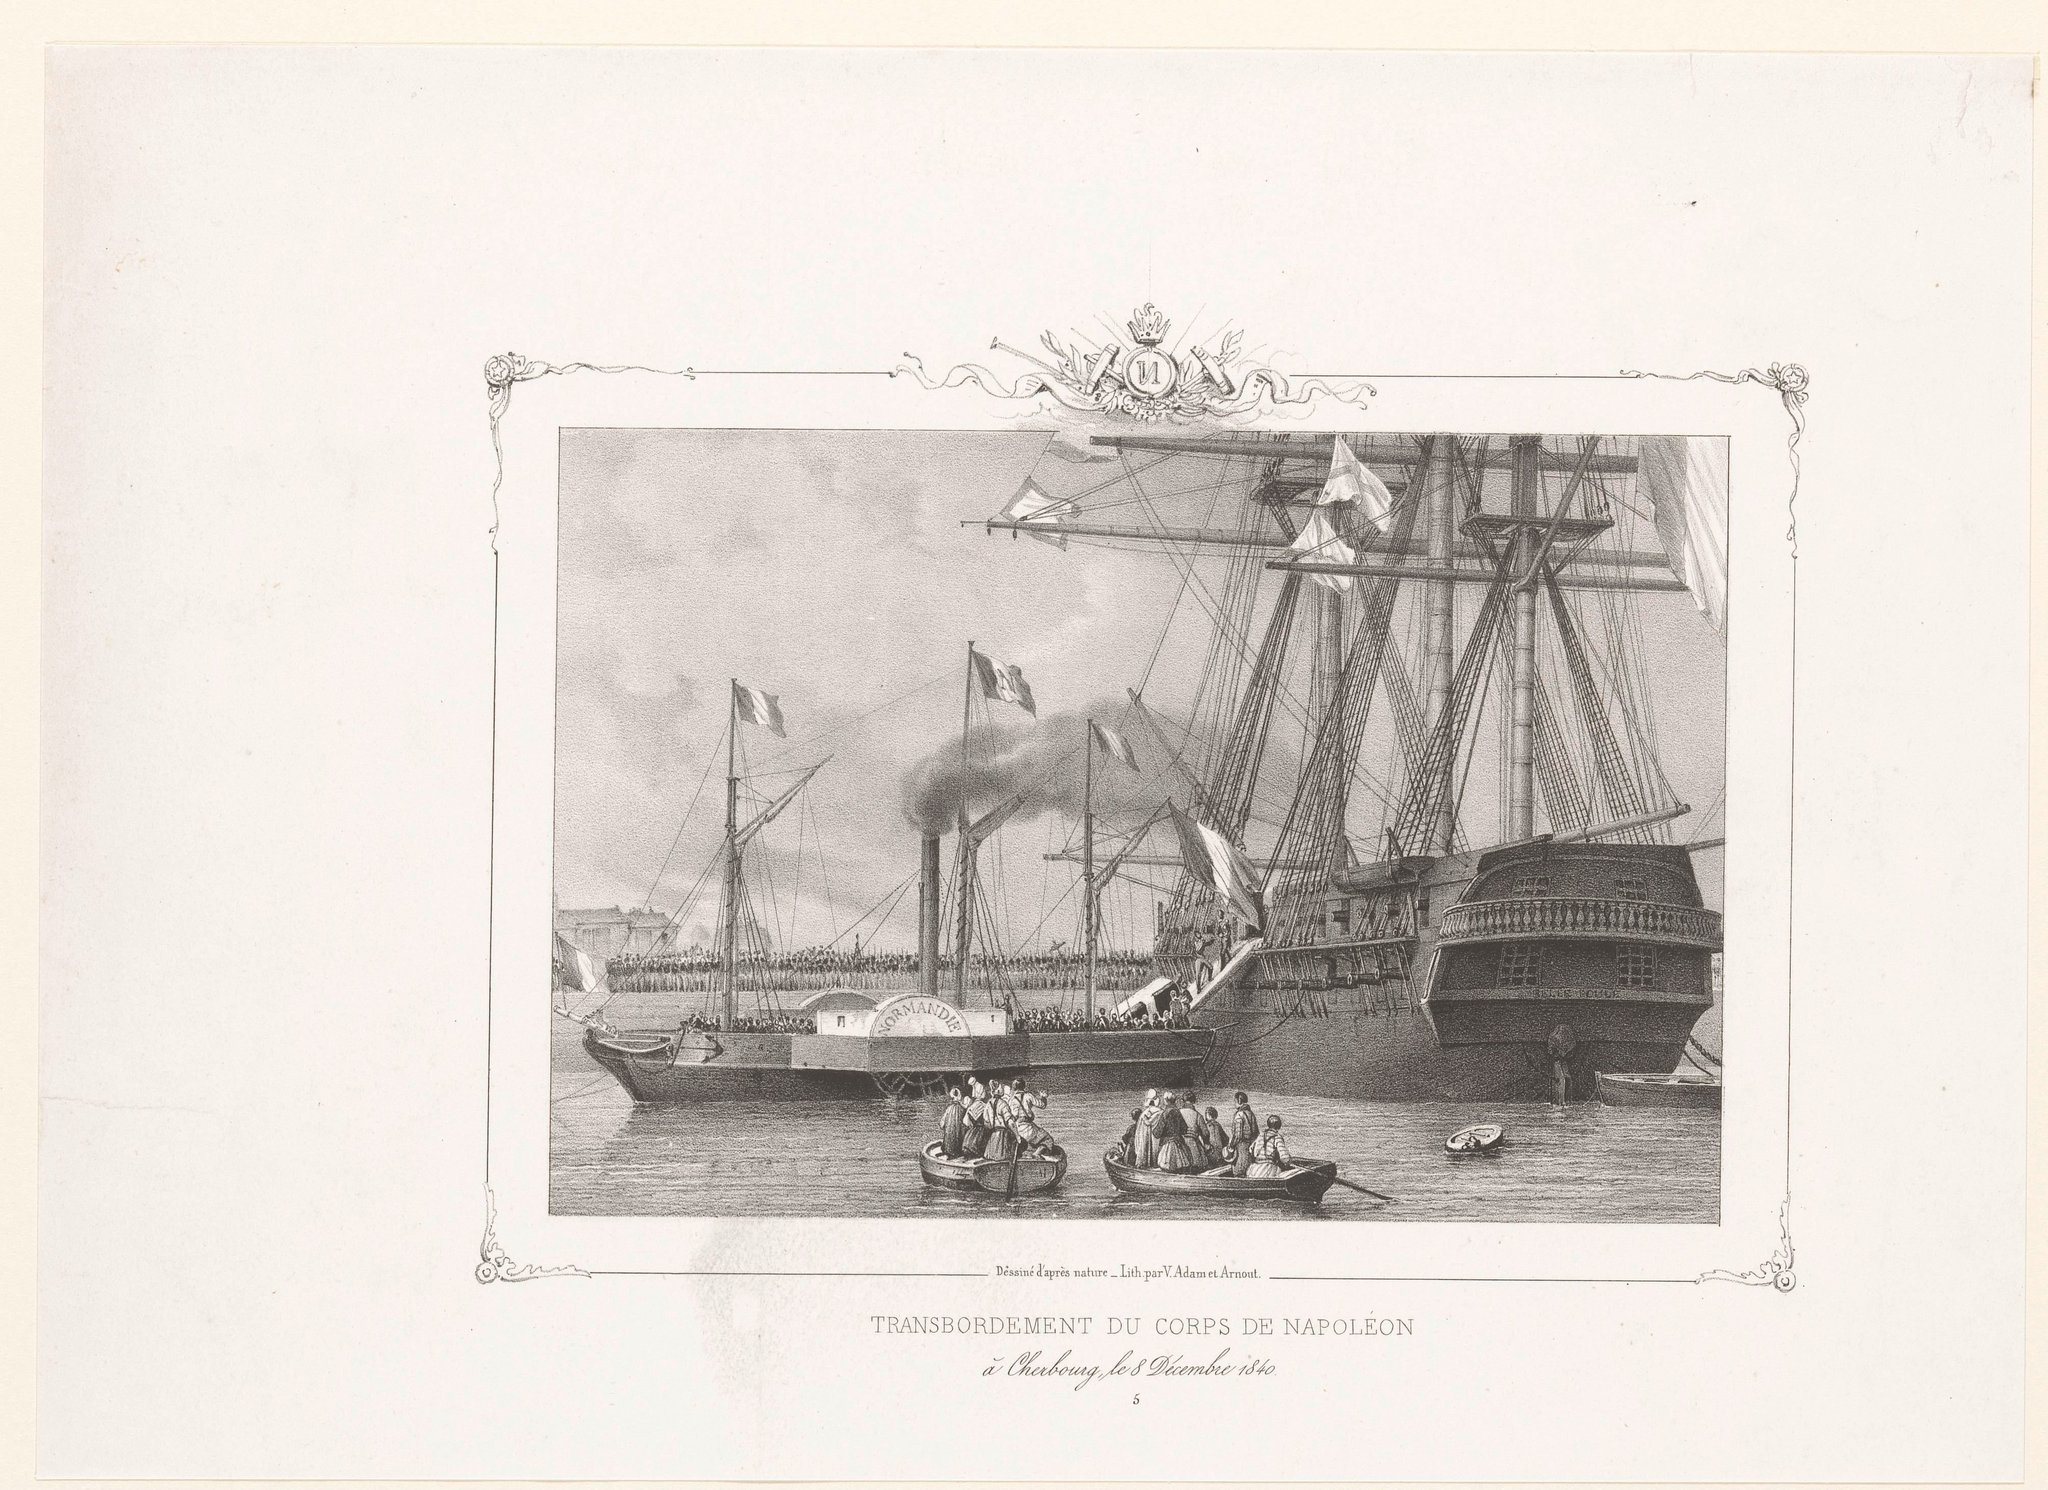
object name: print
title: Retour en France des dépouilles mortelles de Napoléon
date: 1840-1841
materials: paper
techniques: lithograph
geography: paris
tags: napoleon i (emperor of the french), re-burial, ships (in general), coffin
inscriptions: collector's mark: Lugt 2228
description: Deze serie bevat 24 prenten in klein formaat, die een vereenvoudiging zijn van eerder uitgegeven prenten in groot formaat. In 1840 werden de stoffelijke resten van Napoleon op initiatief van Adolphe Thiers en koning Louis-Philippe van Sint-Helena overgebracht naar Parijs (Le retour des cendres). De tekening voor de steendruk is naar het leven gemaakt ('dessiné d'après nature').